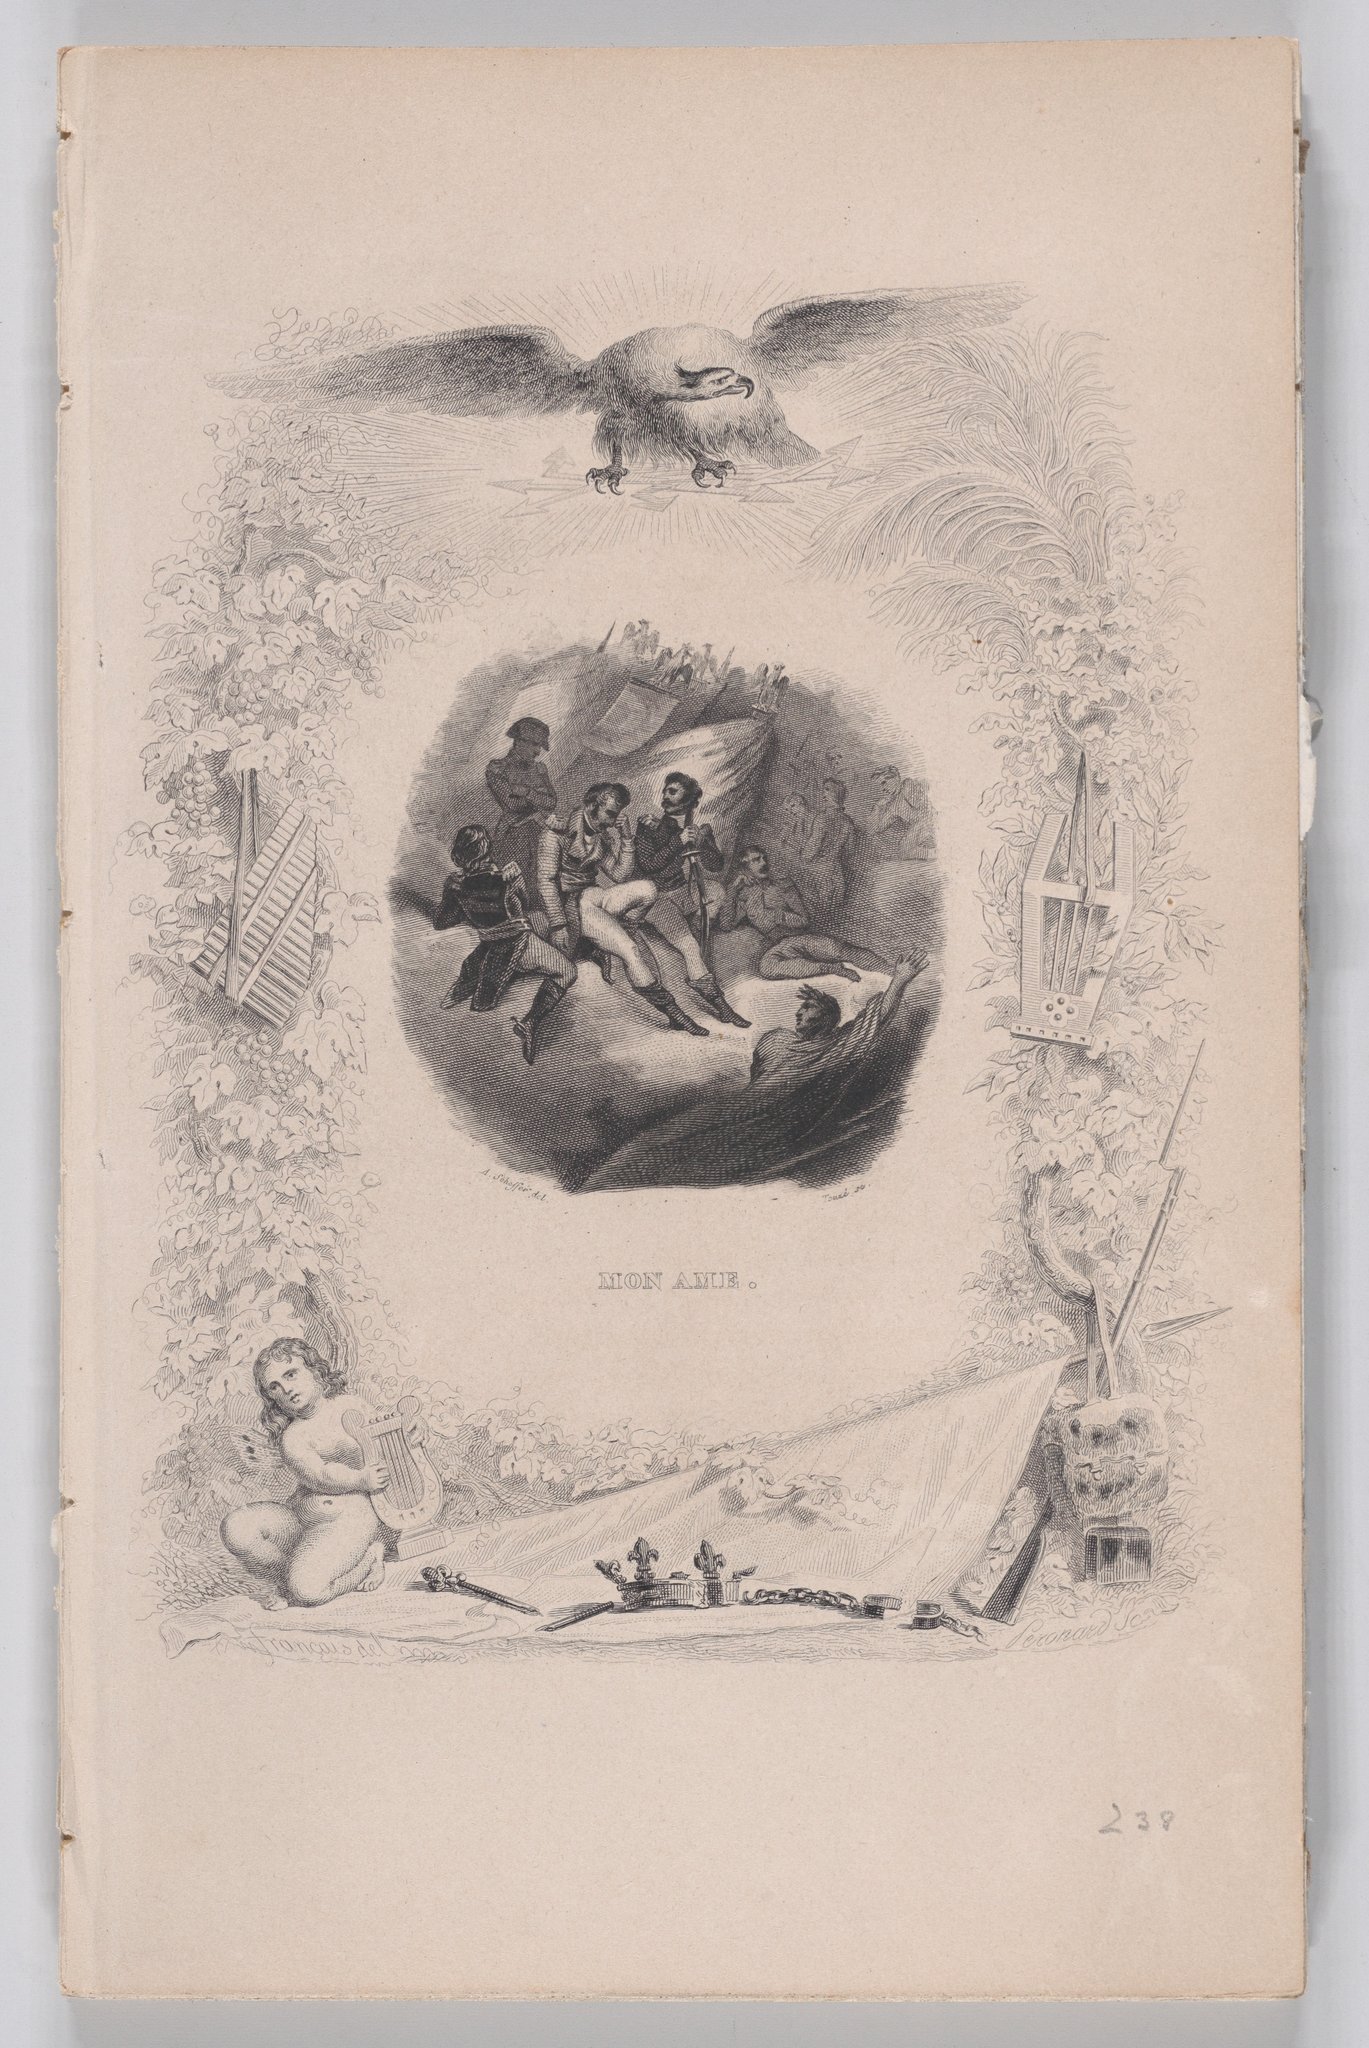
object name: print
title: My Soul, from "The Complete Works of Béranger"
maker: ary scheffer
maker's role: designer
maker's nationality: french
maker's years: 1795-1858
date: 1829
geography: paris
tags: men